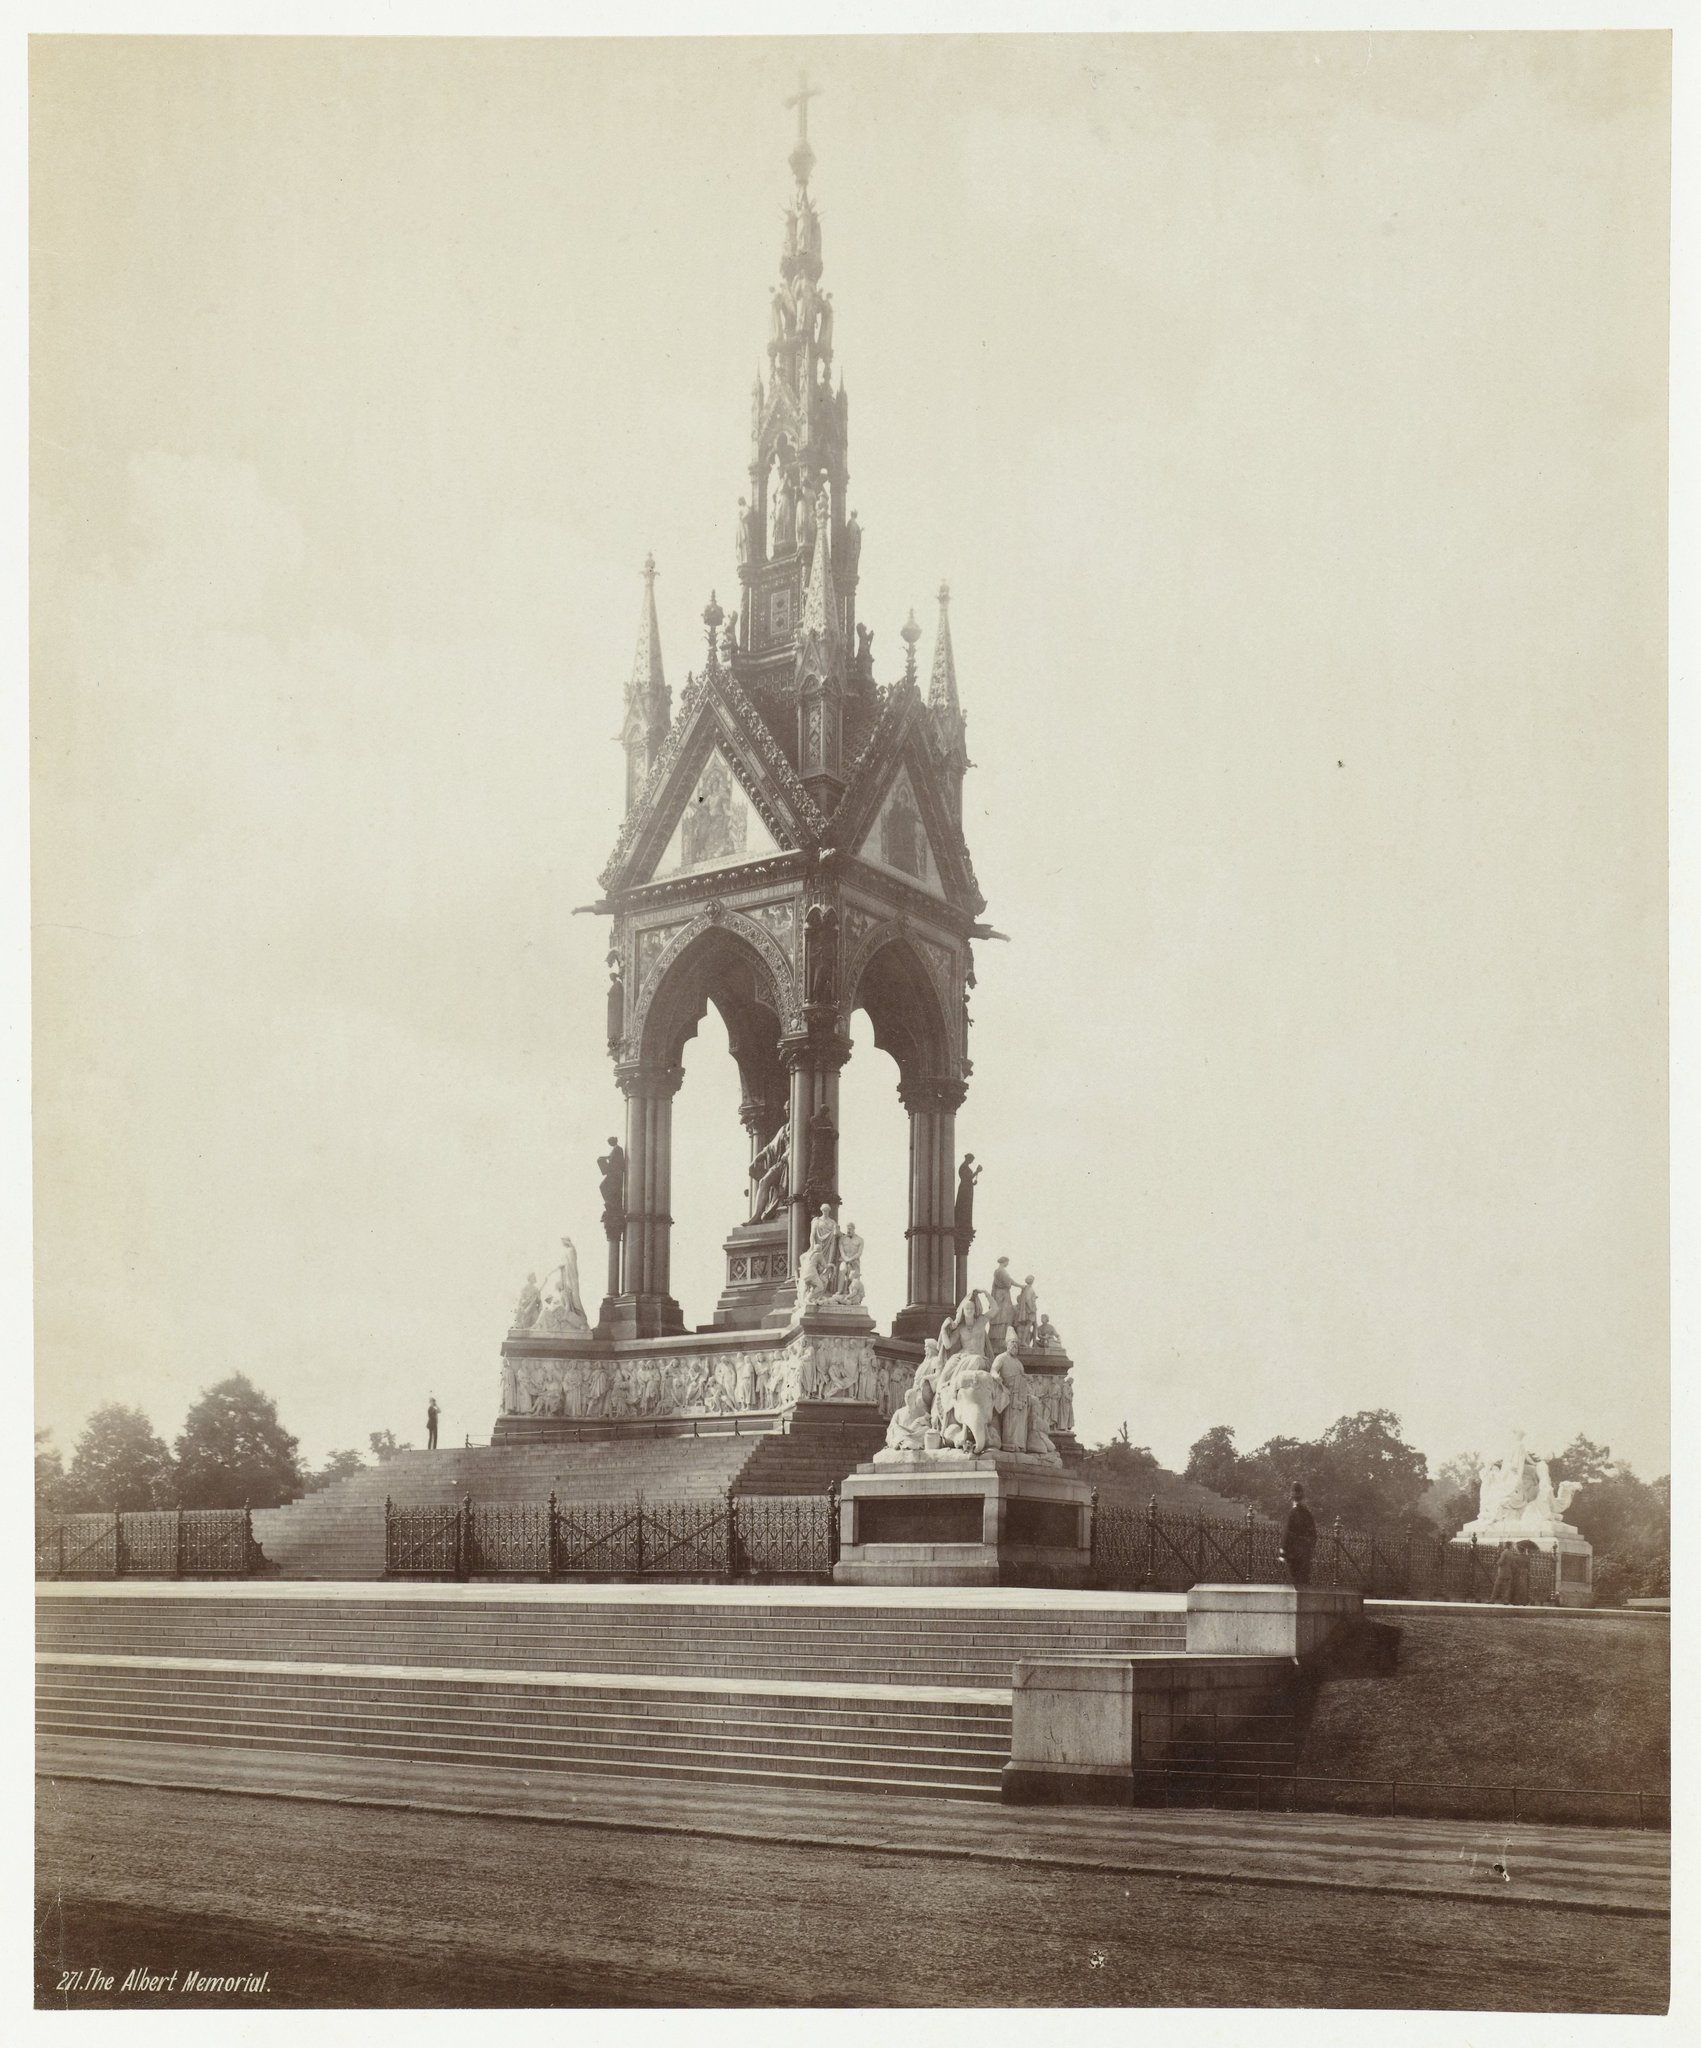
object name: photograph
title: The Albert Memorial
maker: Anonymous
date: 1876-1900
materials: cardboard, paper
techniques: albumen print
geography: kensington gardens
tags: monument, statue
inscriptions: number: ‘271.’